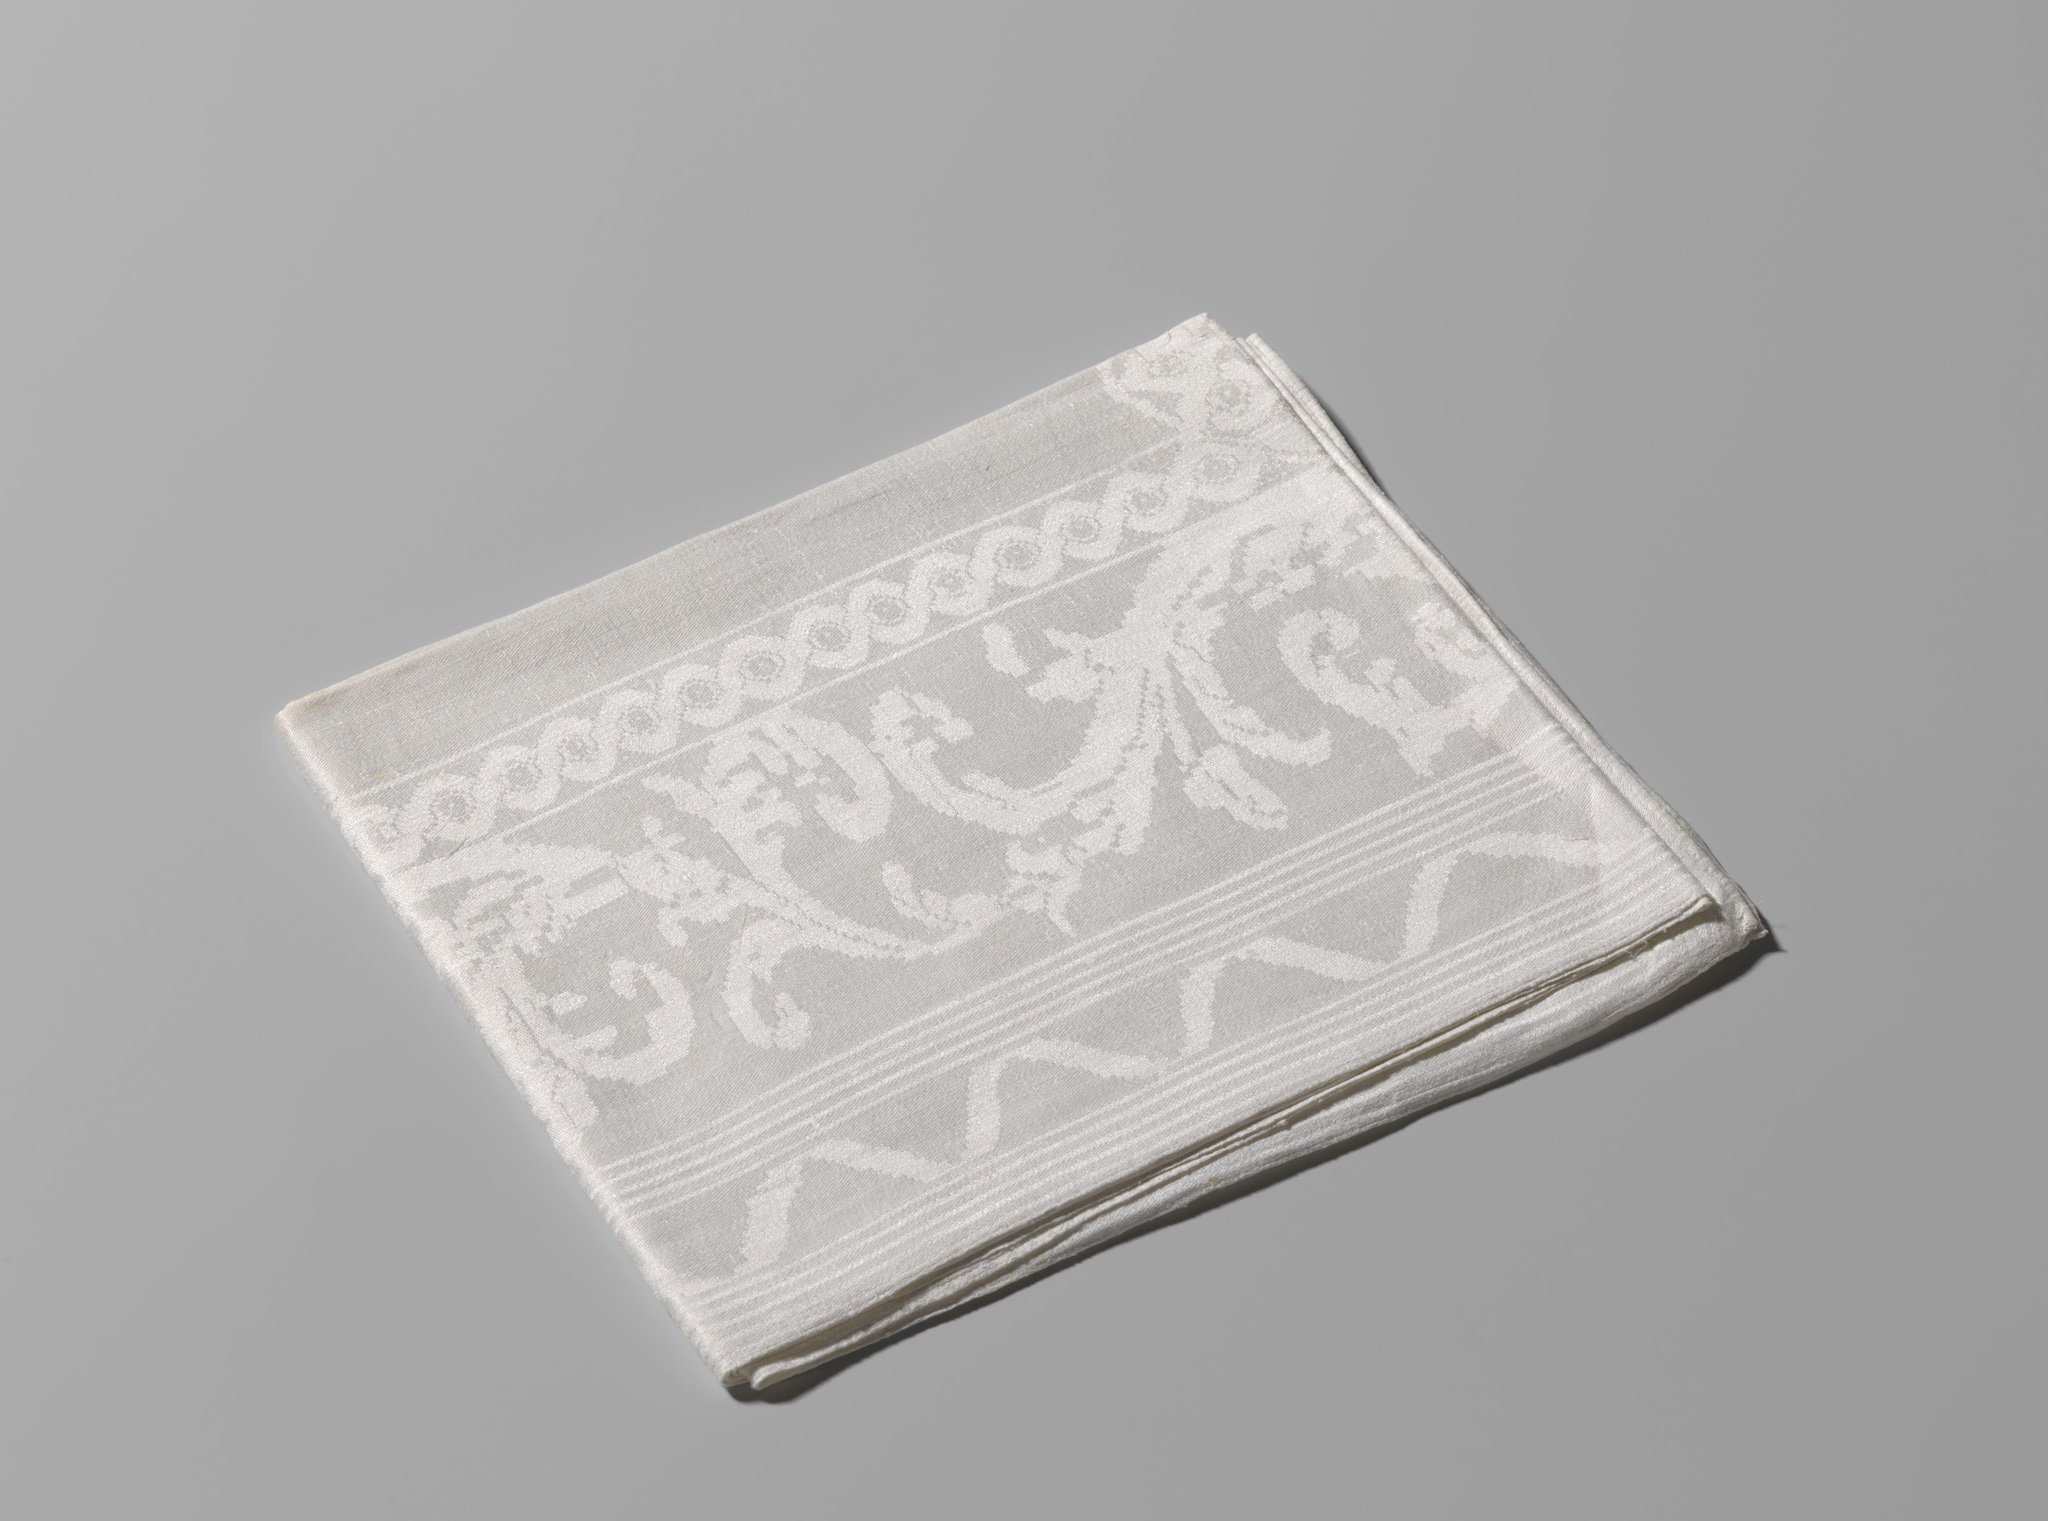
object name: napkin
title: Servet van damast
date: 1757-1800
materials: linen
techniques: damask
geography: northern netherlands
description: Damasten servet met het wapen Quack, gemerkt QW 18.